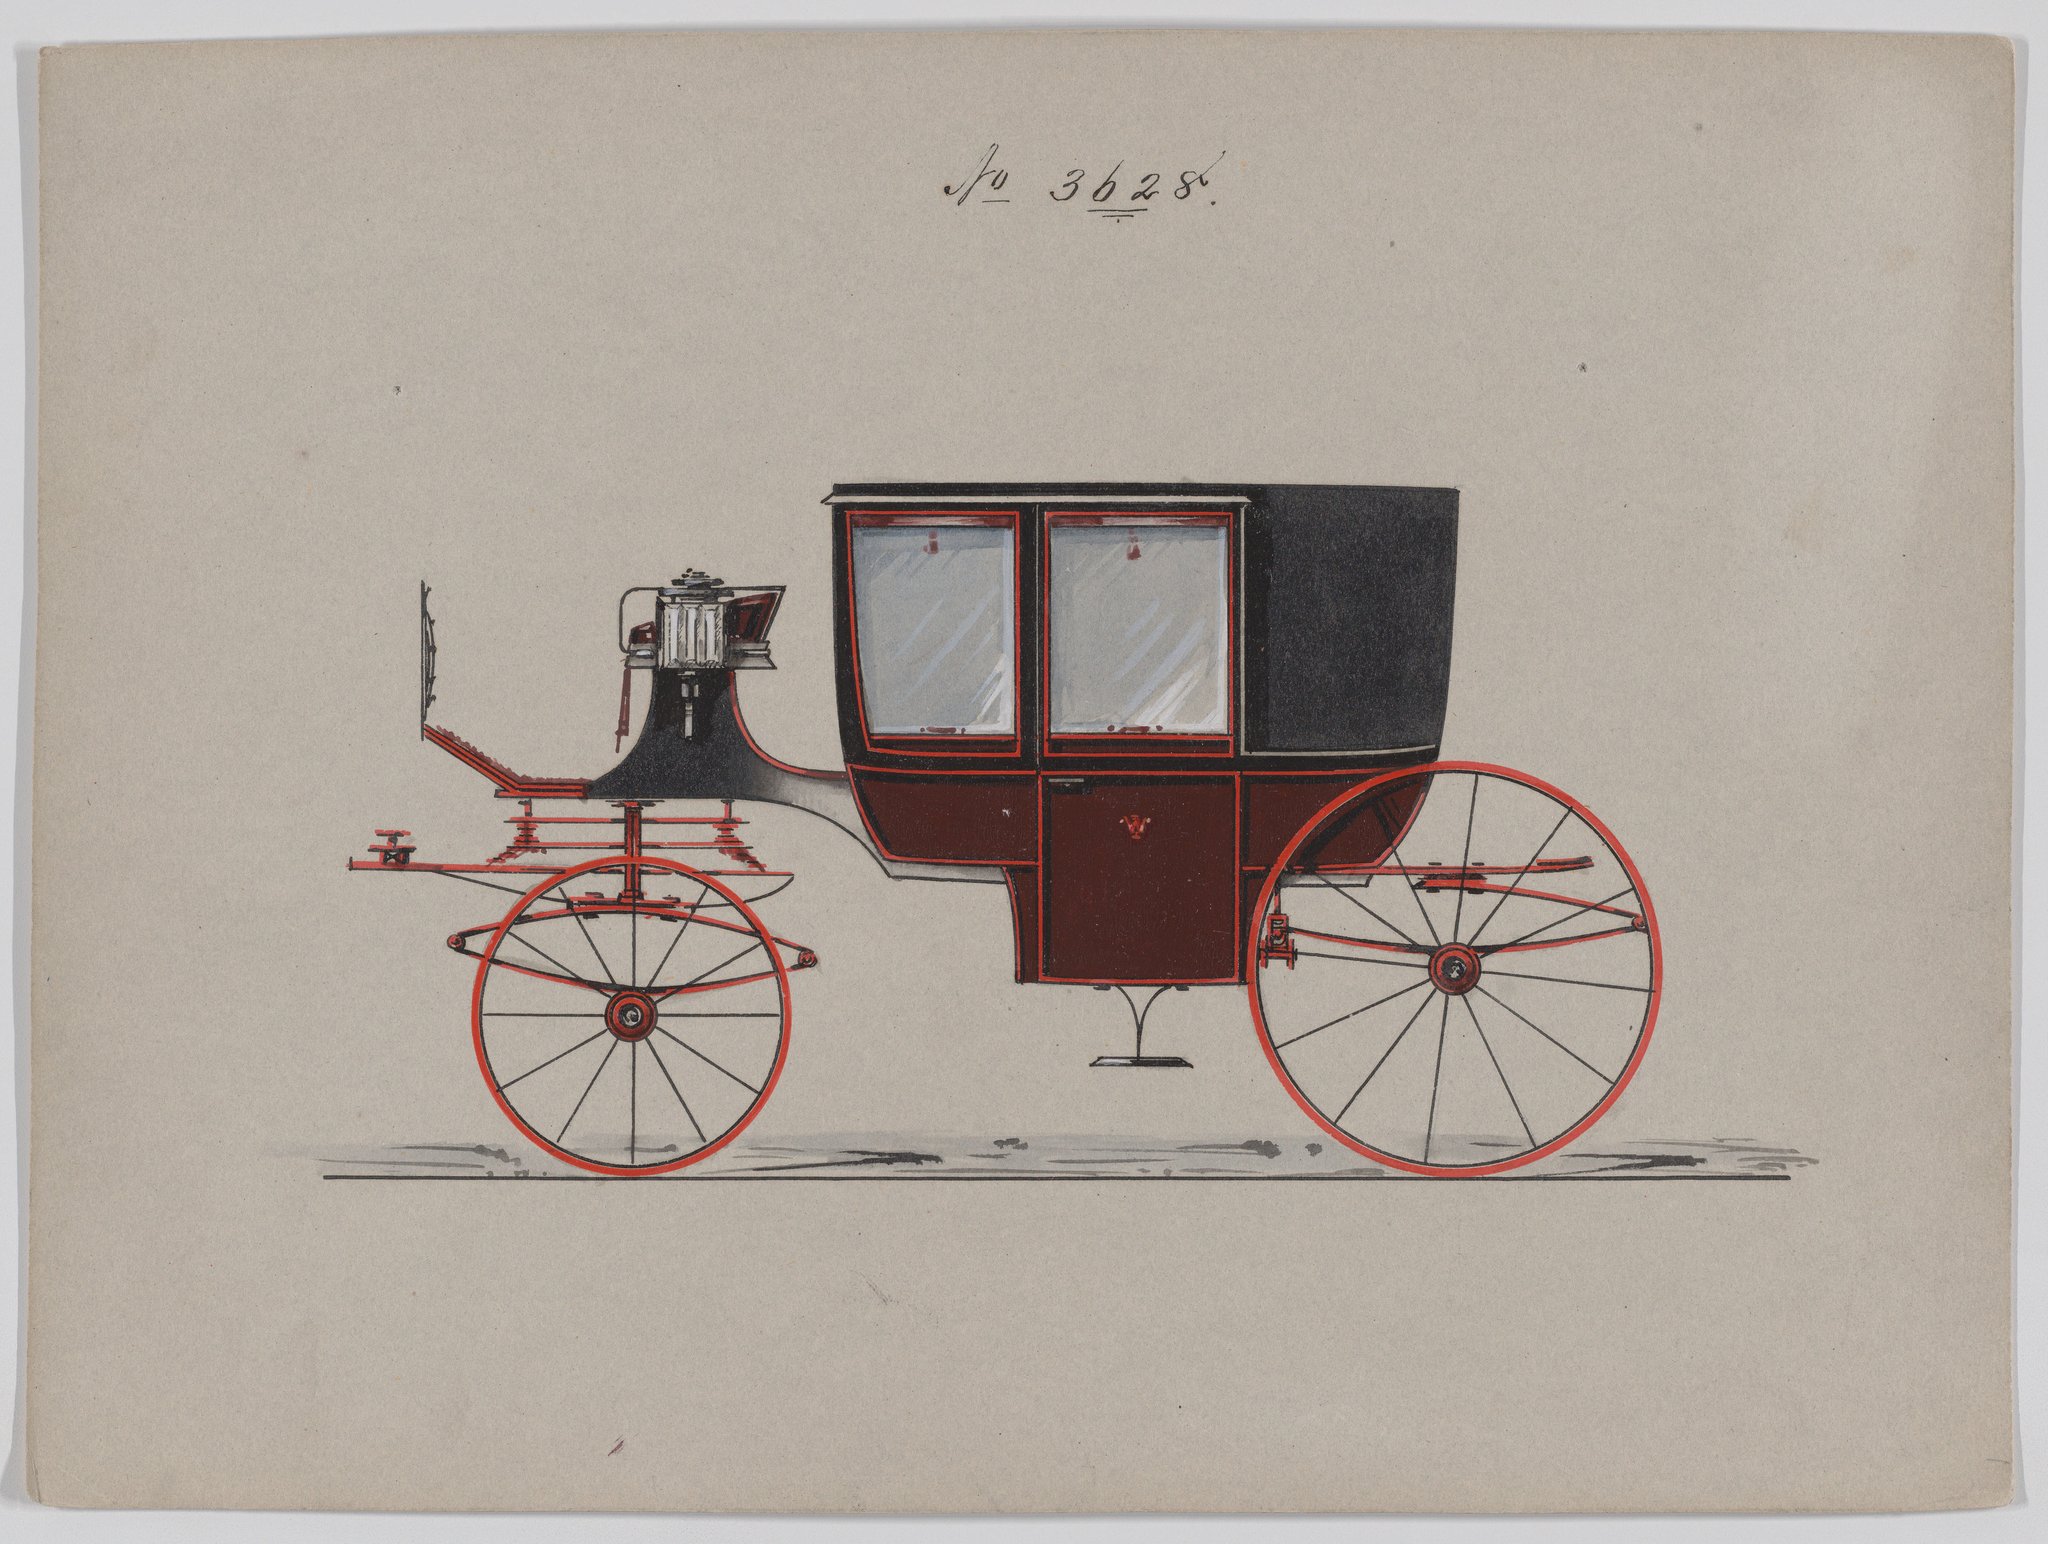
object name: drawing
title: Coach #3628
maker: brewster & co.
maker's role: manufacturer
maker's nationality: american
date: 1880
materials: gouache, gum arabic, ink, watercolor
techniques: pen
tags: carriages